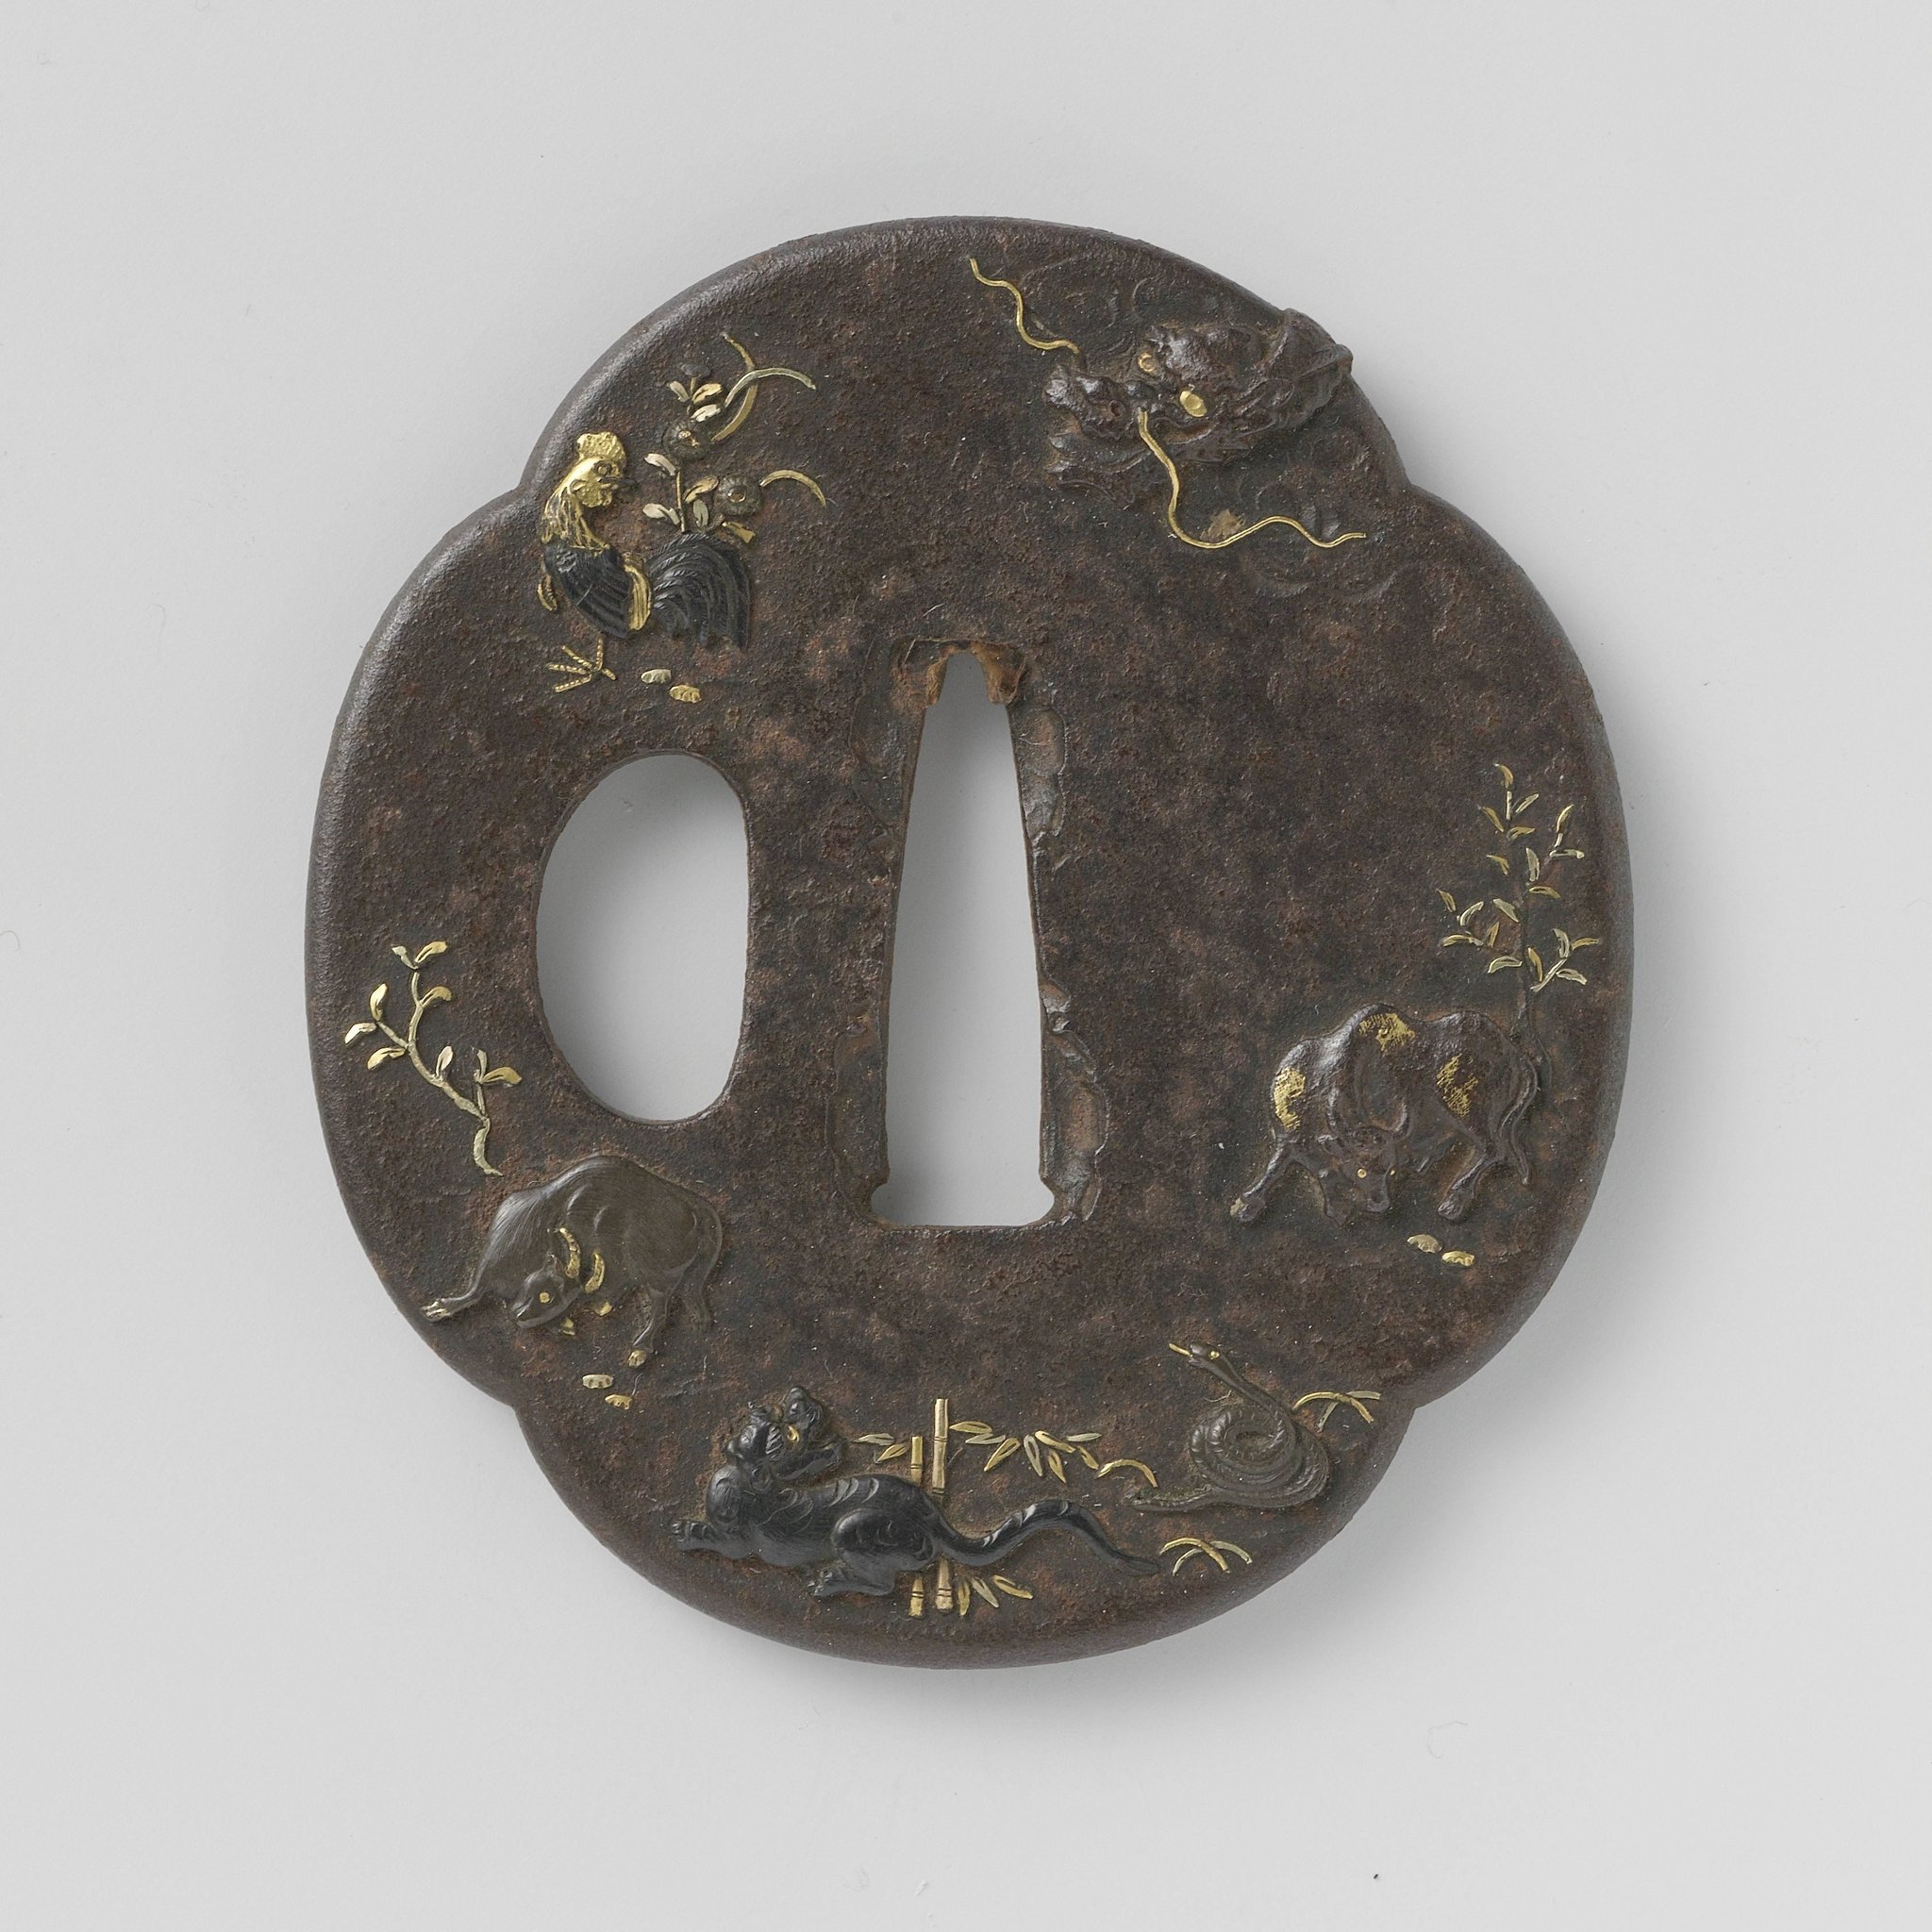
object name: tsuba, zwaardstootplaat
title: Hand guard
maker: Anonymous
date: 1700-1900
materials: gold, iron, silver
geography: japan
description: Mokko-vormige tsuba met in iroe-taka-zogan de twaalf dieren van de zodiac.